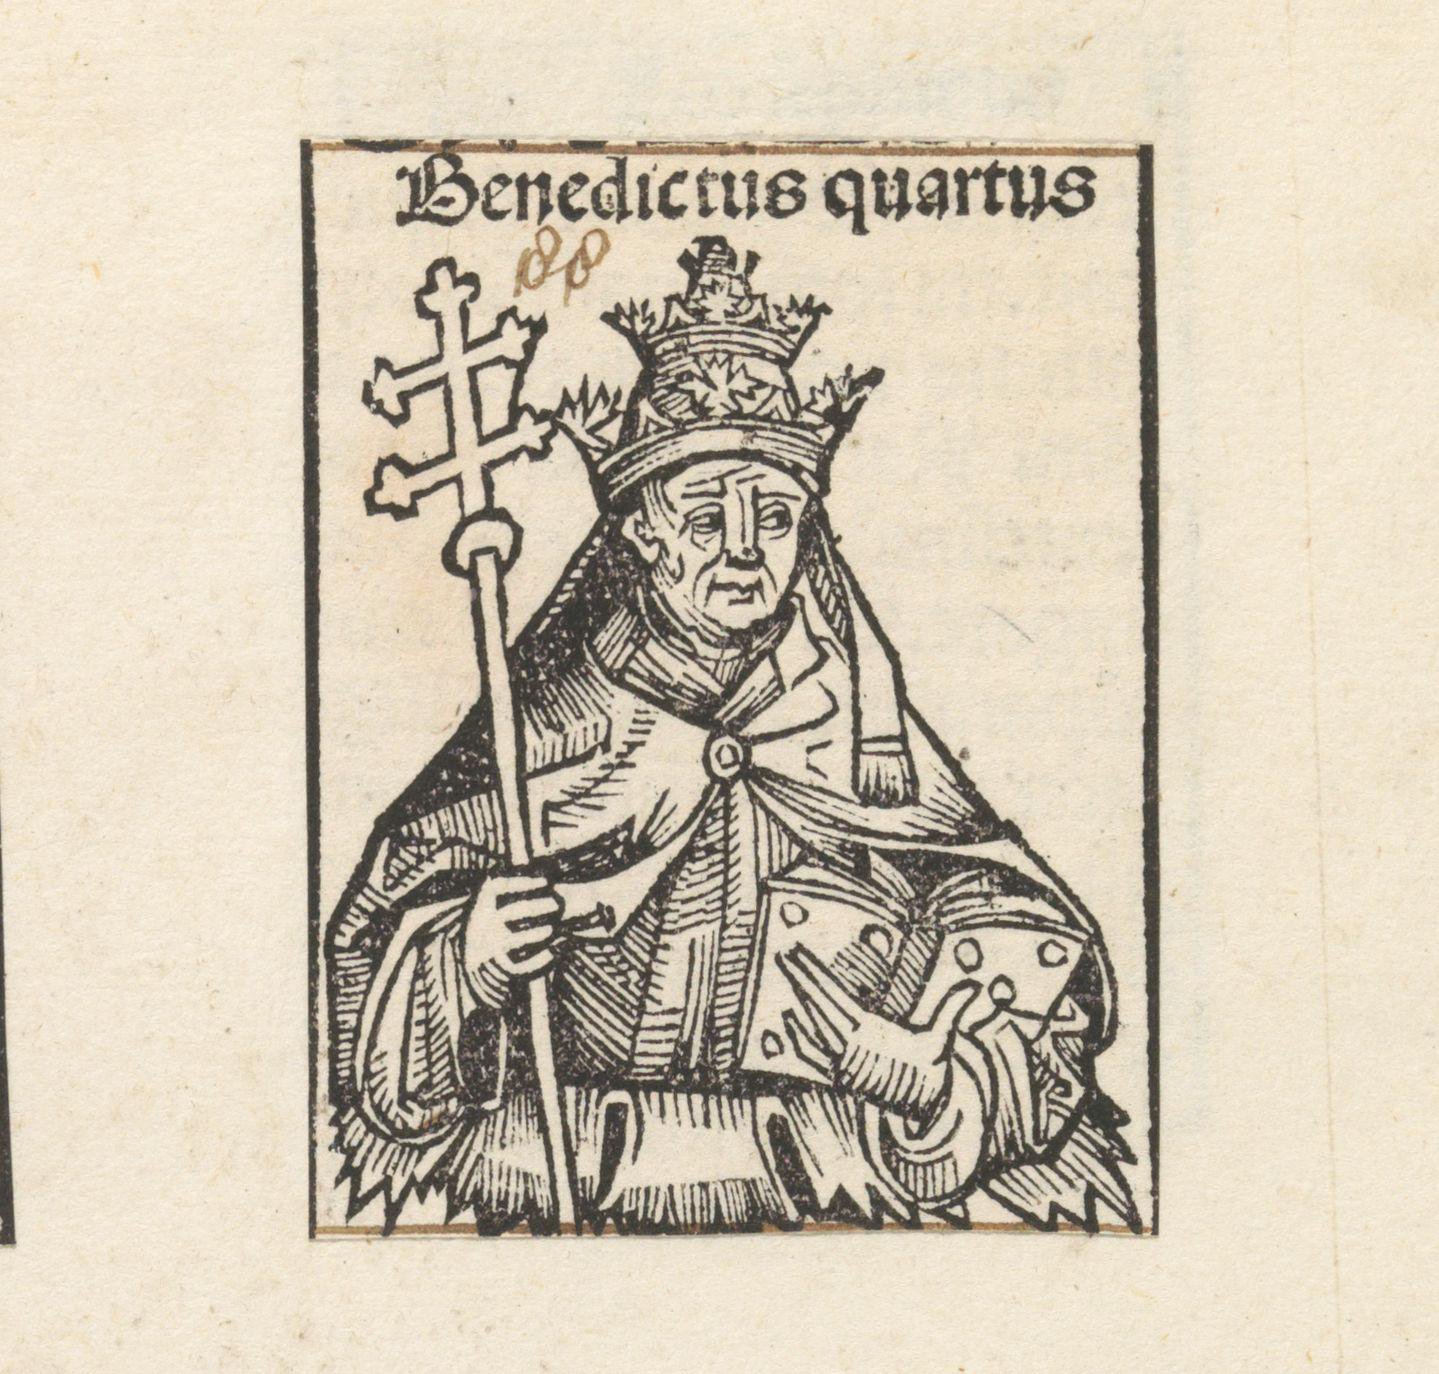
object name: book illustration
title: Benedictus quartus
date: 1493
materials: paper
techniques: letterpress printing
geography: nuremberg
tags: rome, pope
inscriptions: inscription: ‘88’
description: Een bloemkelk met een paus. Hij draagt een tiara en heeft een opengeslagen boek en een staf met een dubbel kruis in zijn handen. De voorstelling is onderdeel van de opeenvolging pausen in de Liber Chronicarum. De tekst identificeert de man als Benedictus IV. De prent maakt deel uit van een album.